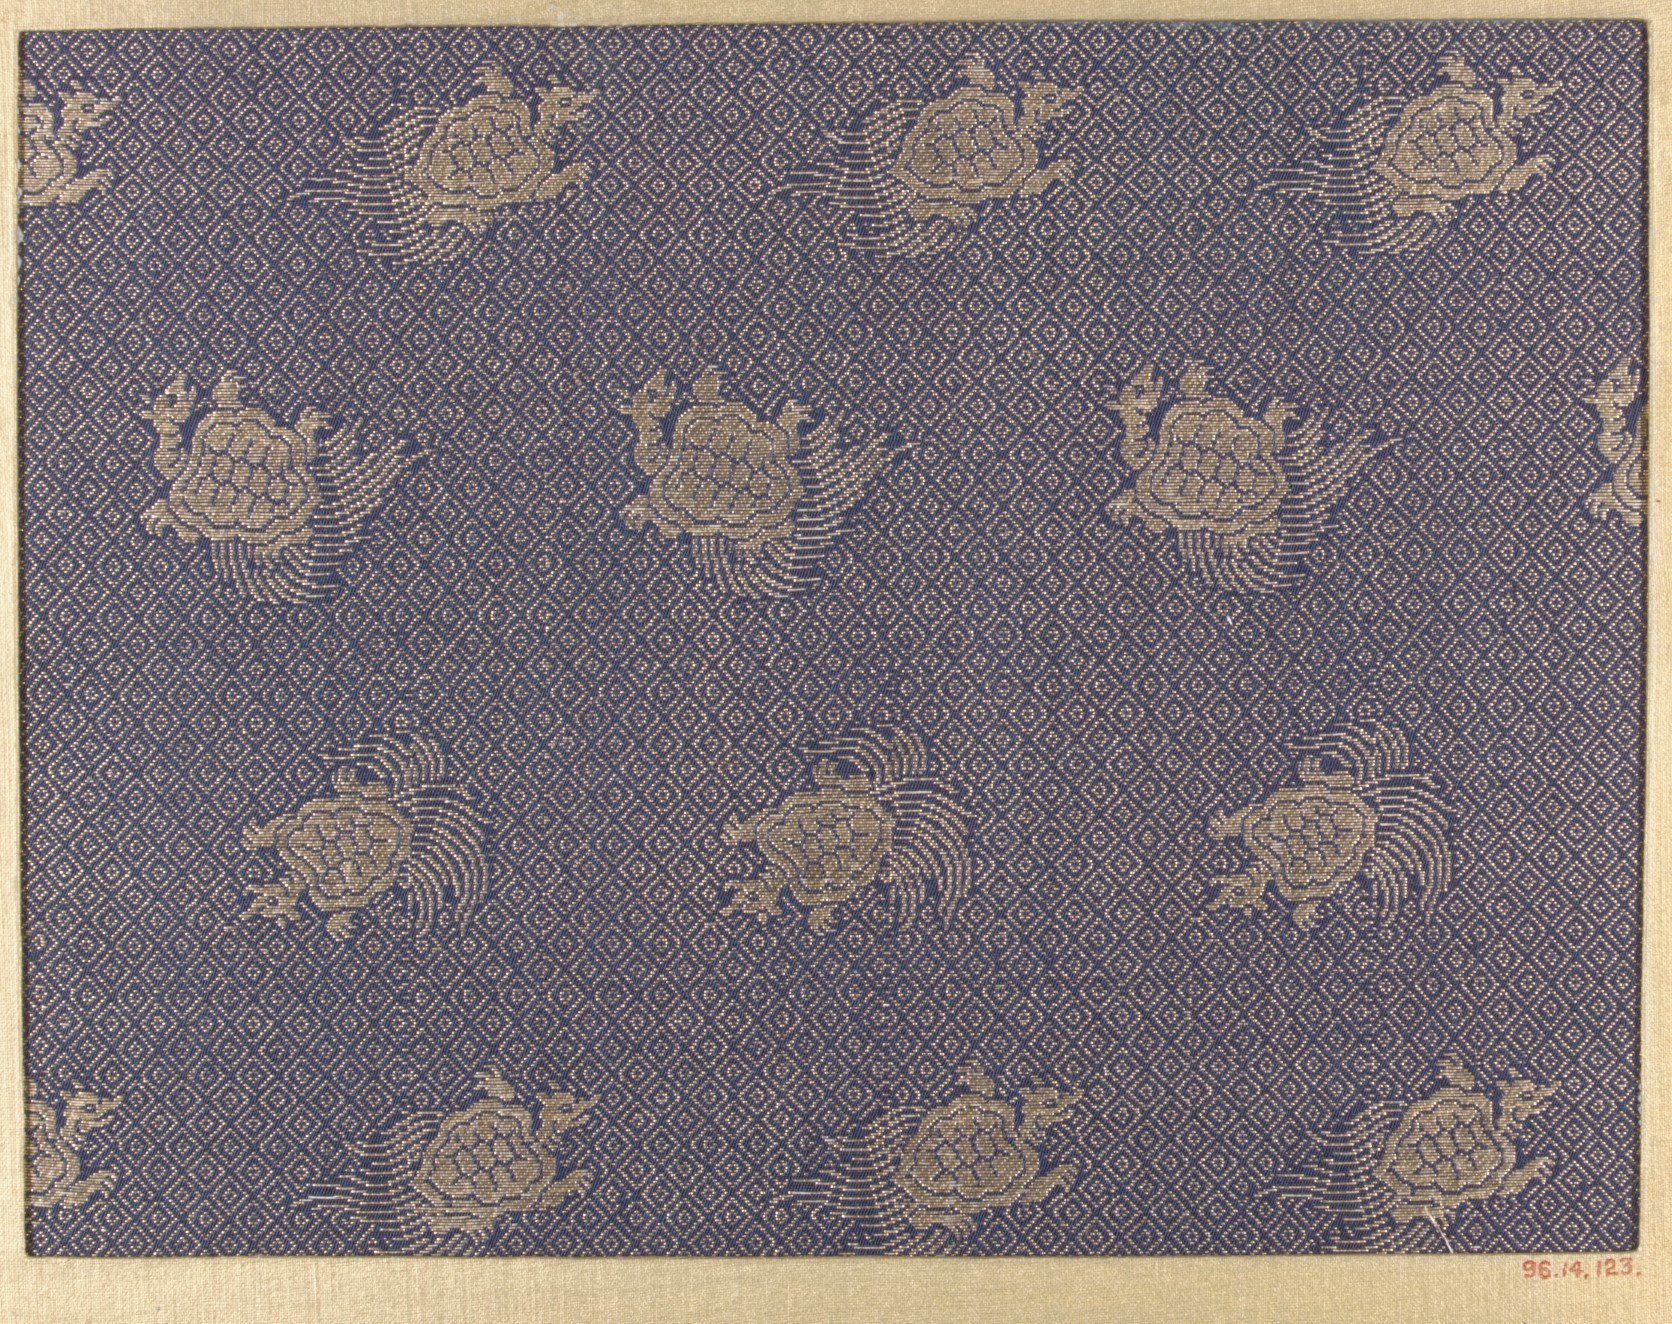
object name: piece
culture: japanese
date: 1701-1900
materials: silk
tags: turtles